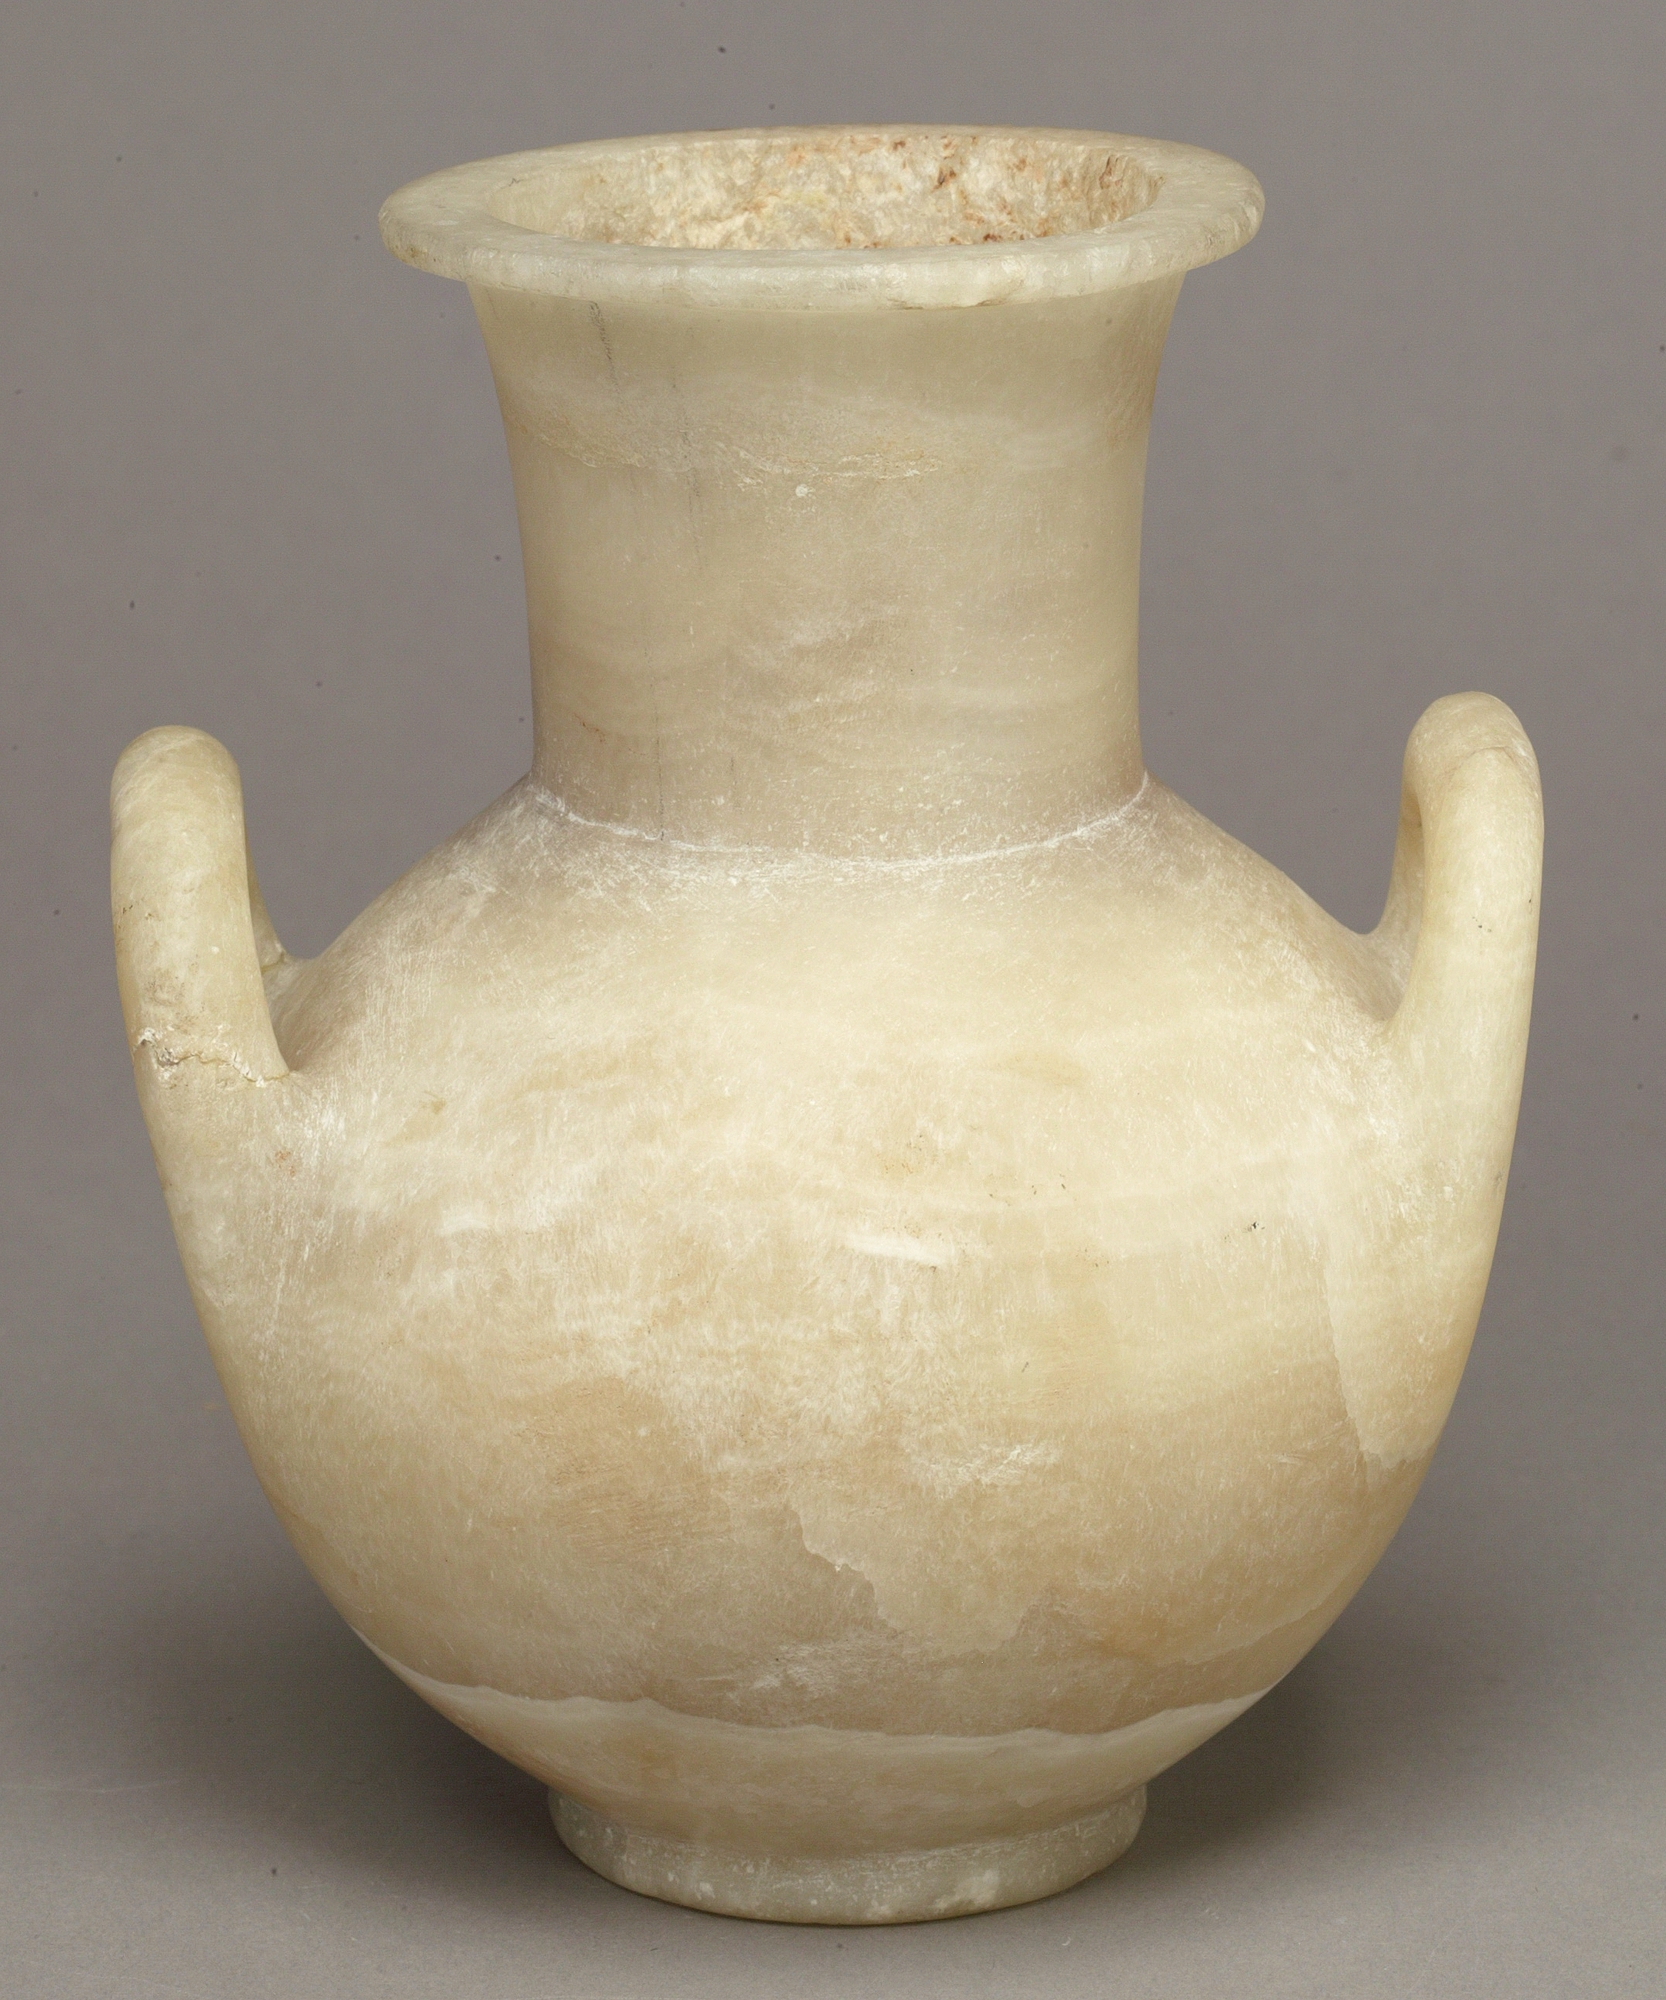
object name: jar, ointment, two handled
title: Two-Handled Ointment Jar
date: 1479-1425 BCE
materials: stone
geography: egypt